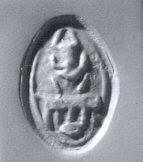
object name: stamp seal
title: Cowroid seal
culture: egyptian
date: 1479-1425 BCE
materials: stone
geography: egypt